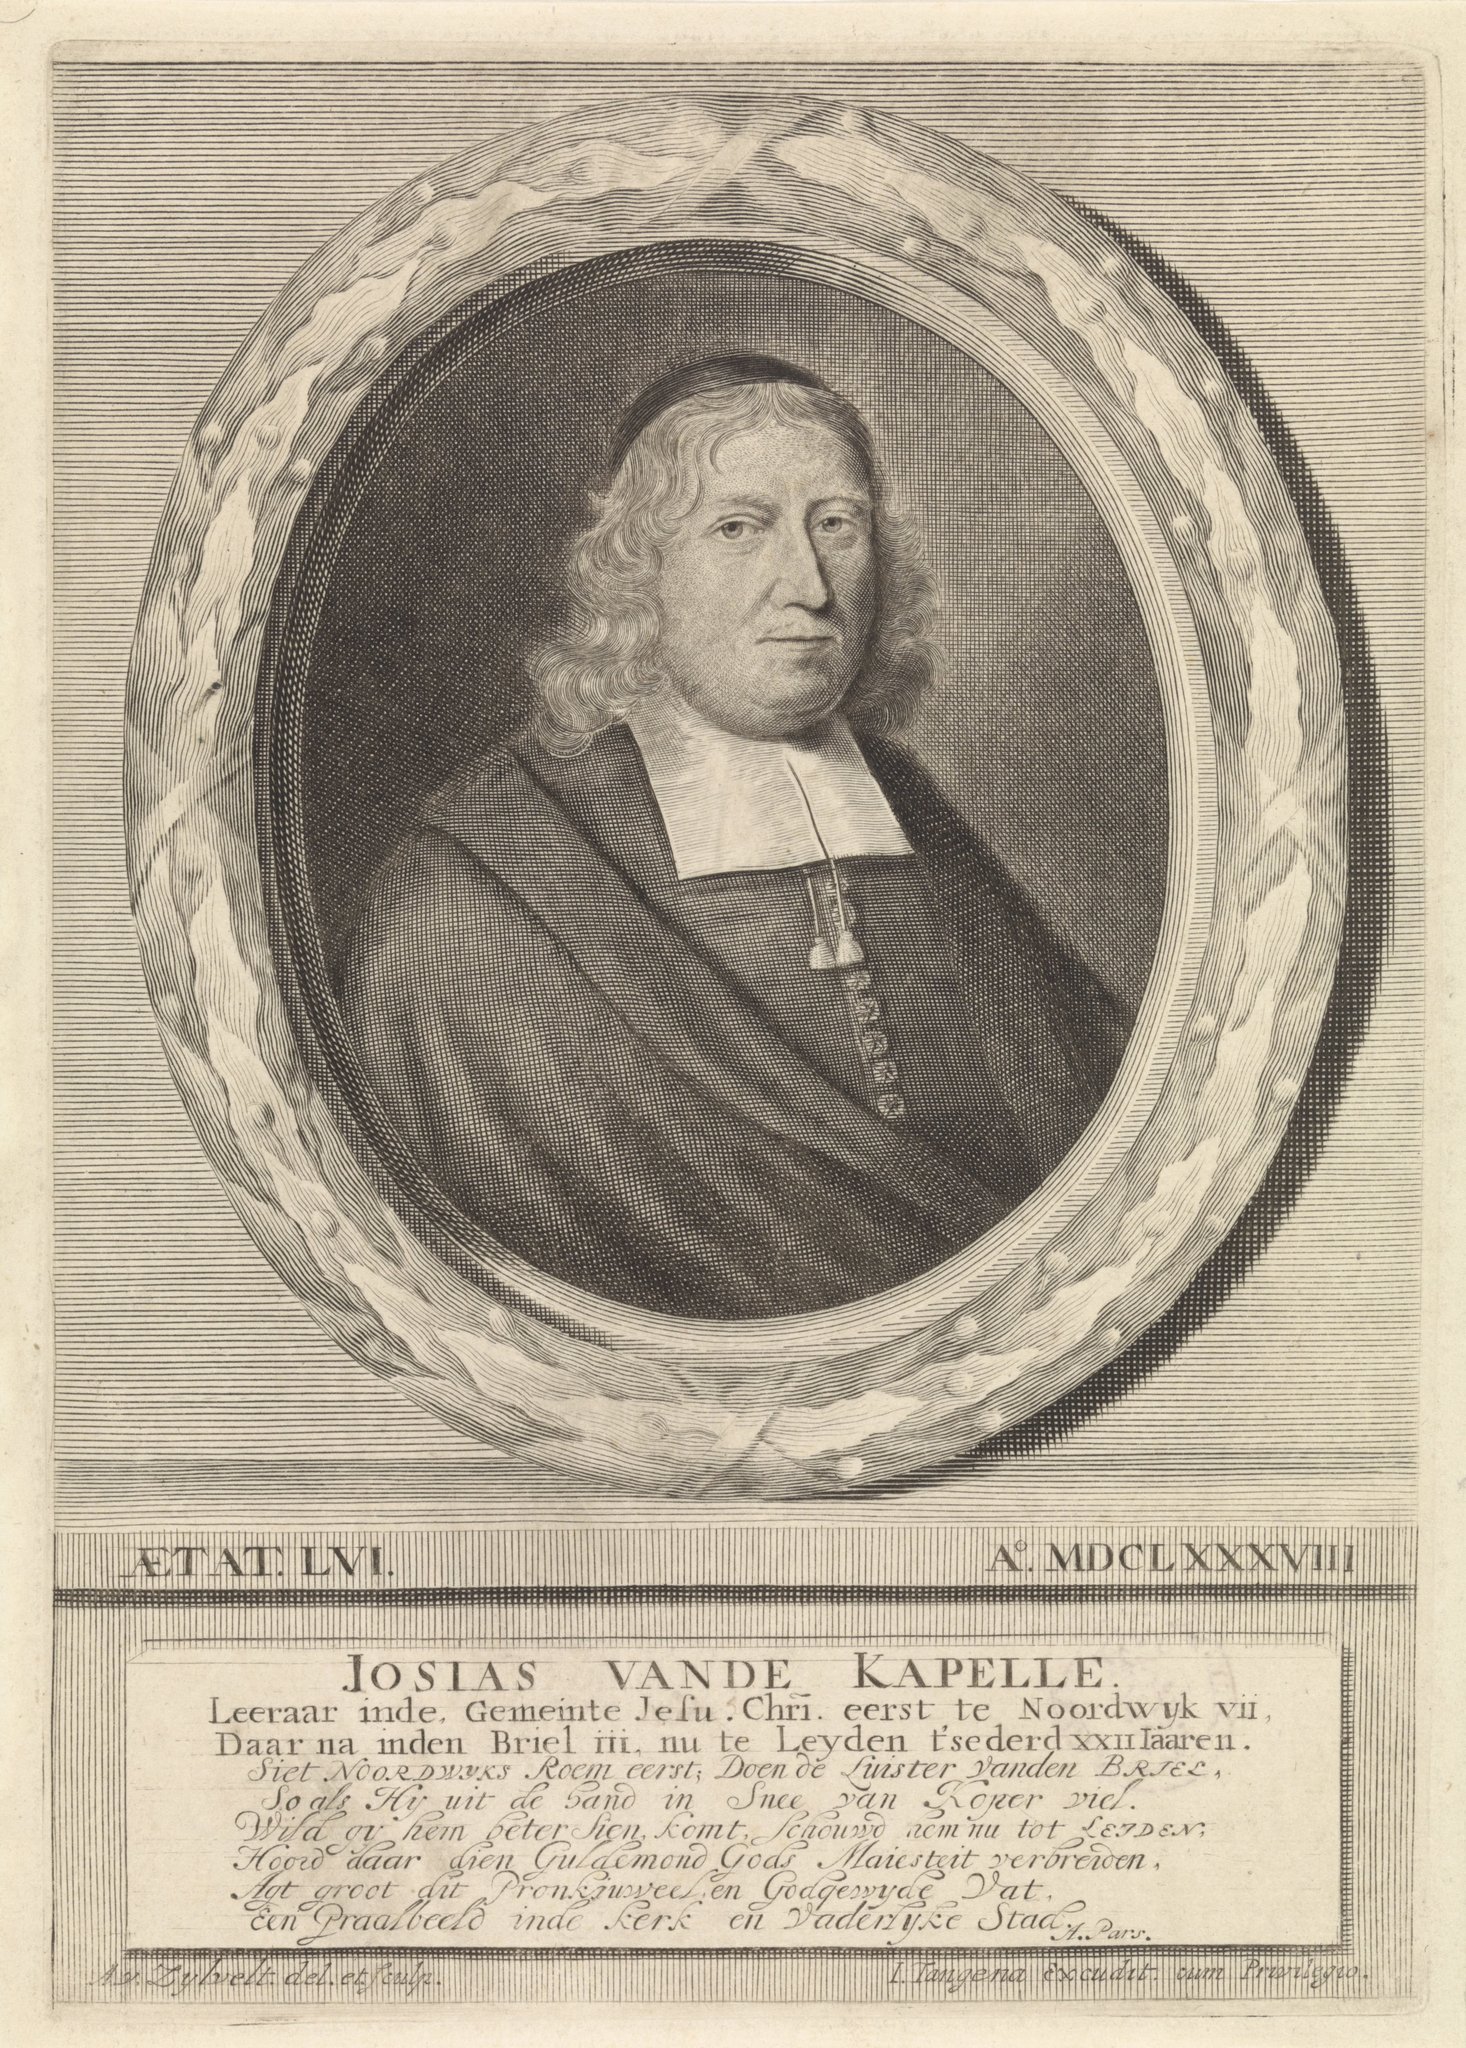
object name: print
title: Portret van Josias van der Kapelle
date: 1688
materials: paper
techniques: engraving, etching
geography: leiden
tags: leiden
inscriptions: collector's mark: Lugt 240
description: Portret van Josias van der Kapelle, predikant te Leiden op 56-jarige leeftijd. Op de sokkel een zesregelig vers in het Nederlands.